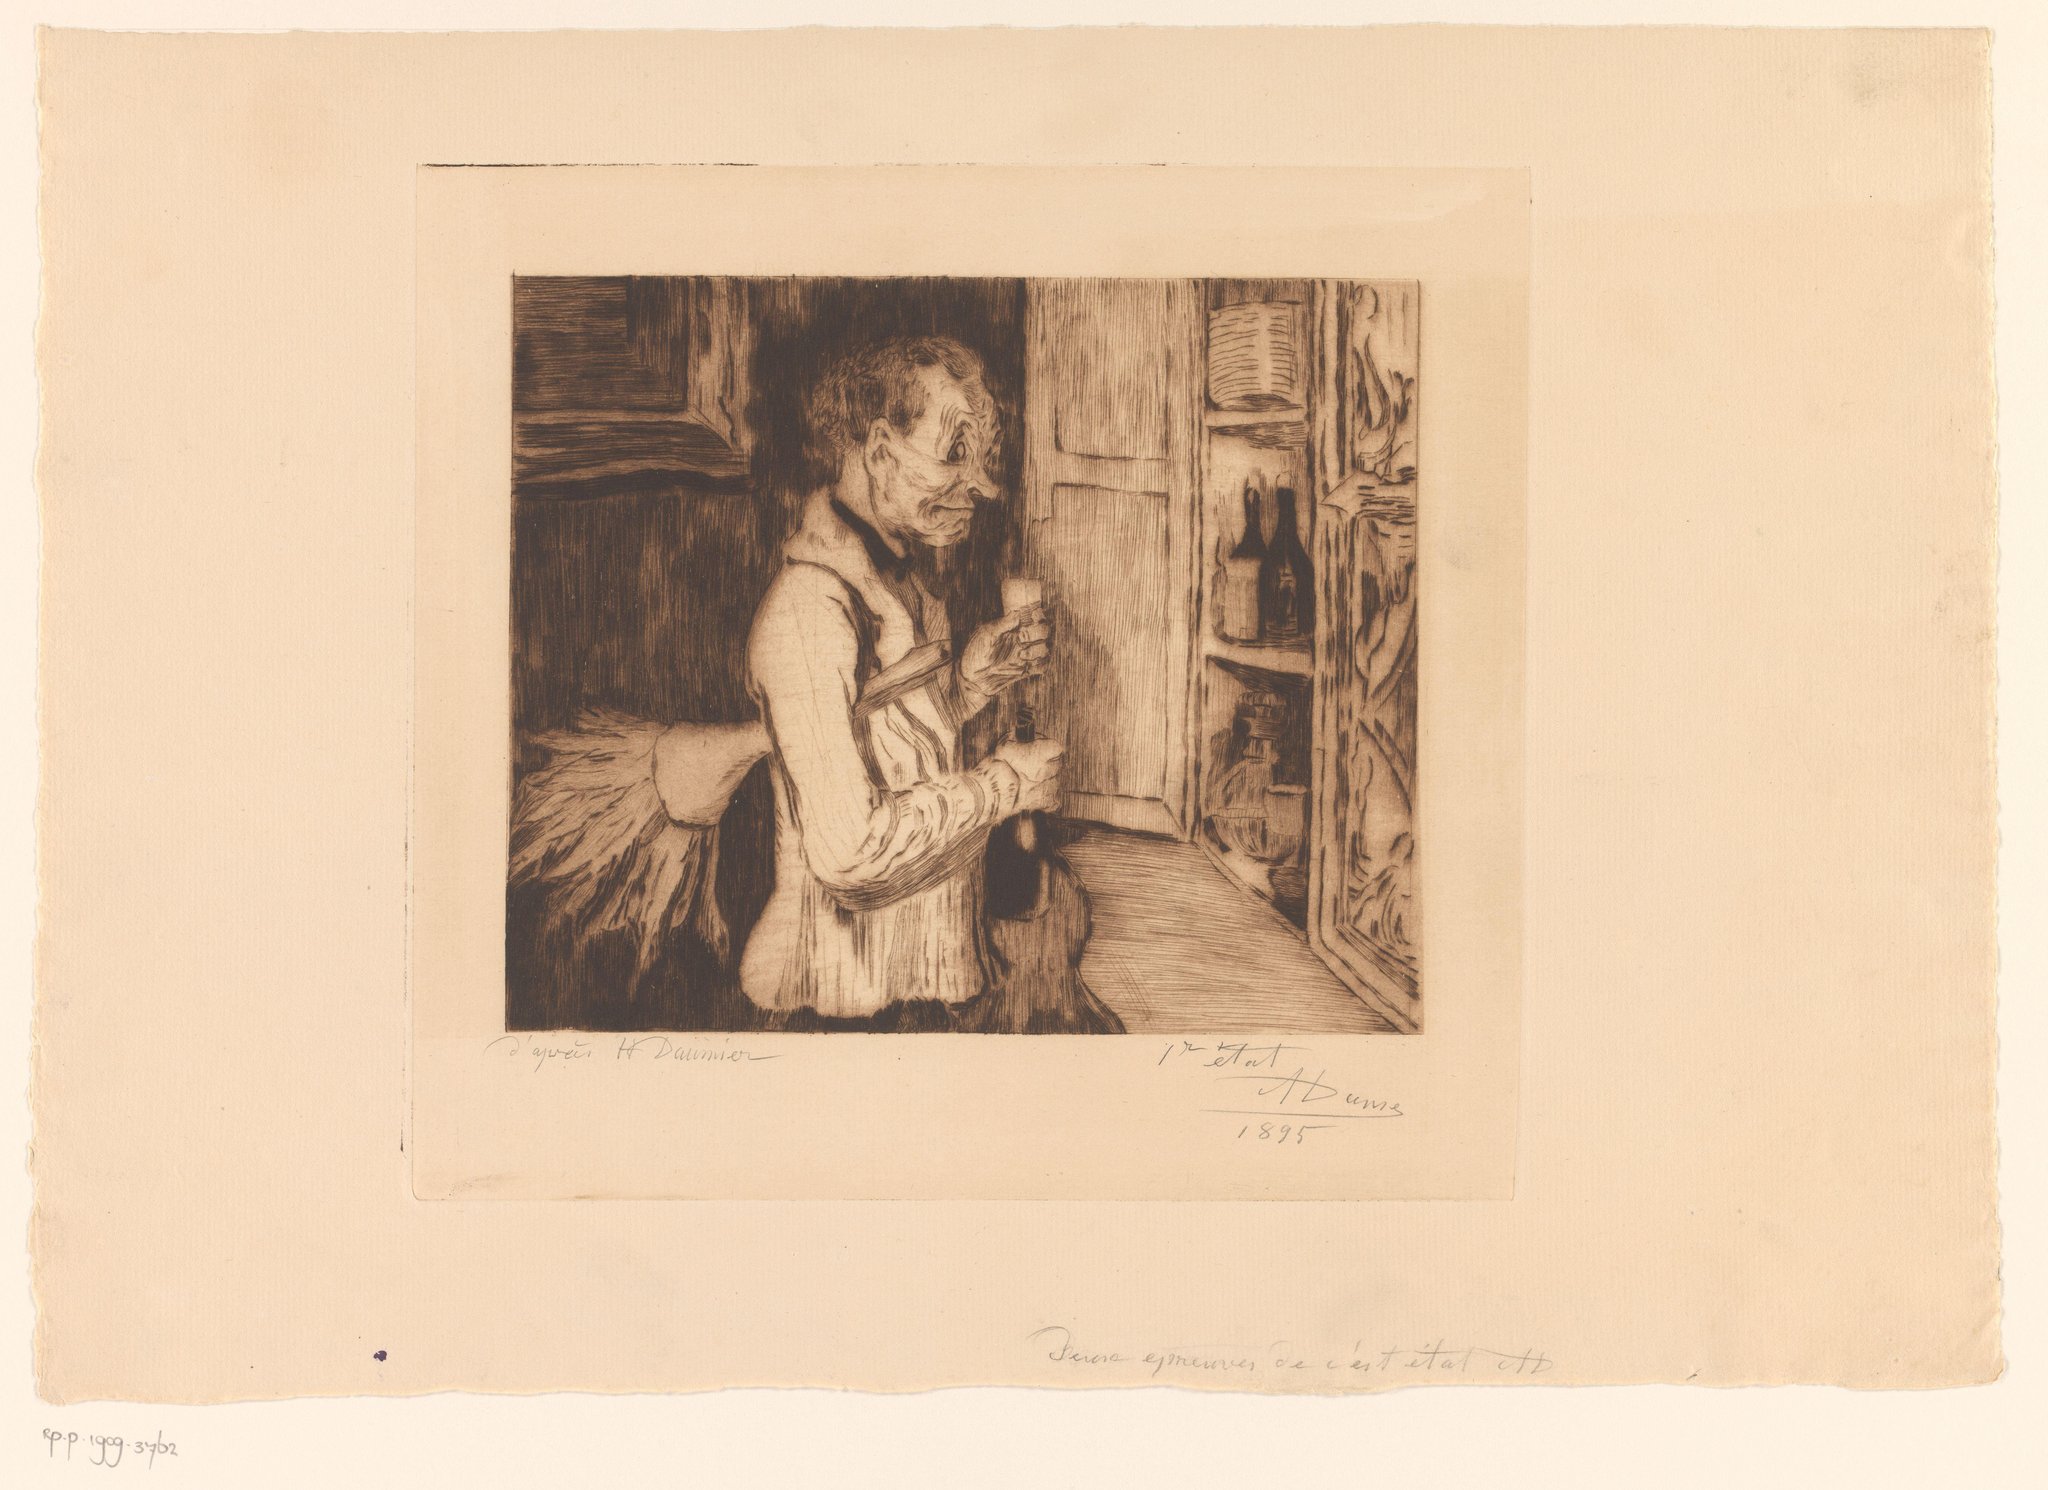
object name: print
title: Butler met een plumeau bij de drankenkast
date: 1895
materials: paper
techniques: drypoint, etching, intaglio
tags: taste, tasting (one of the five senses), butler, alcoholic drinks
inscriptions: annotation: ‘1er état; deux epreuves de c'est état’, collector's mark: Lugt 2228